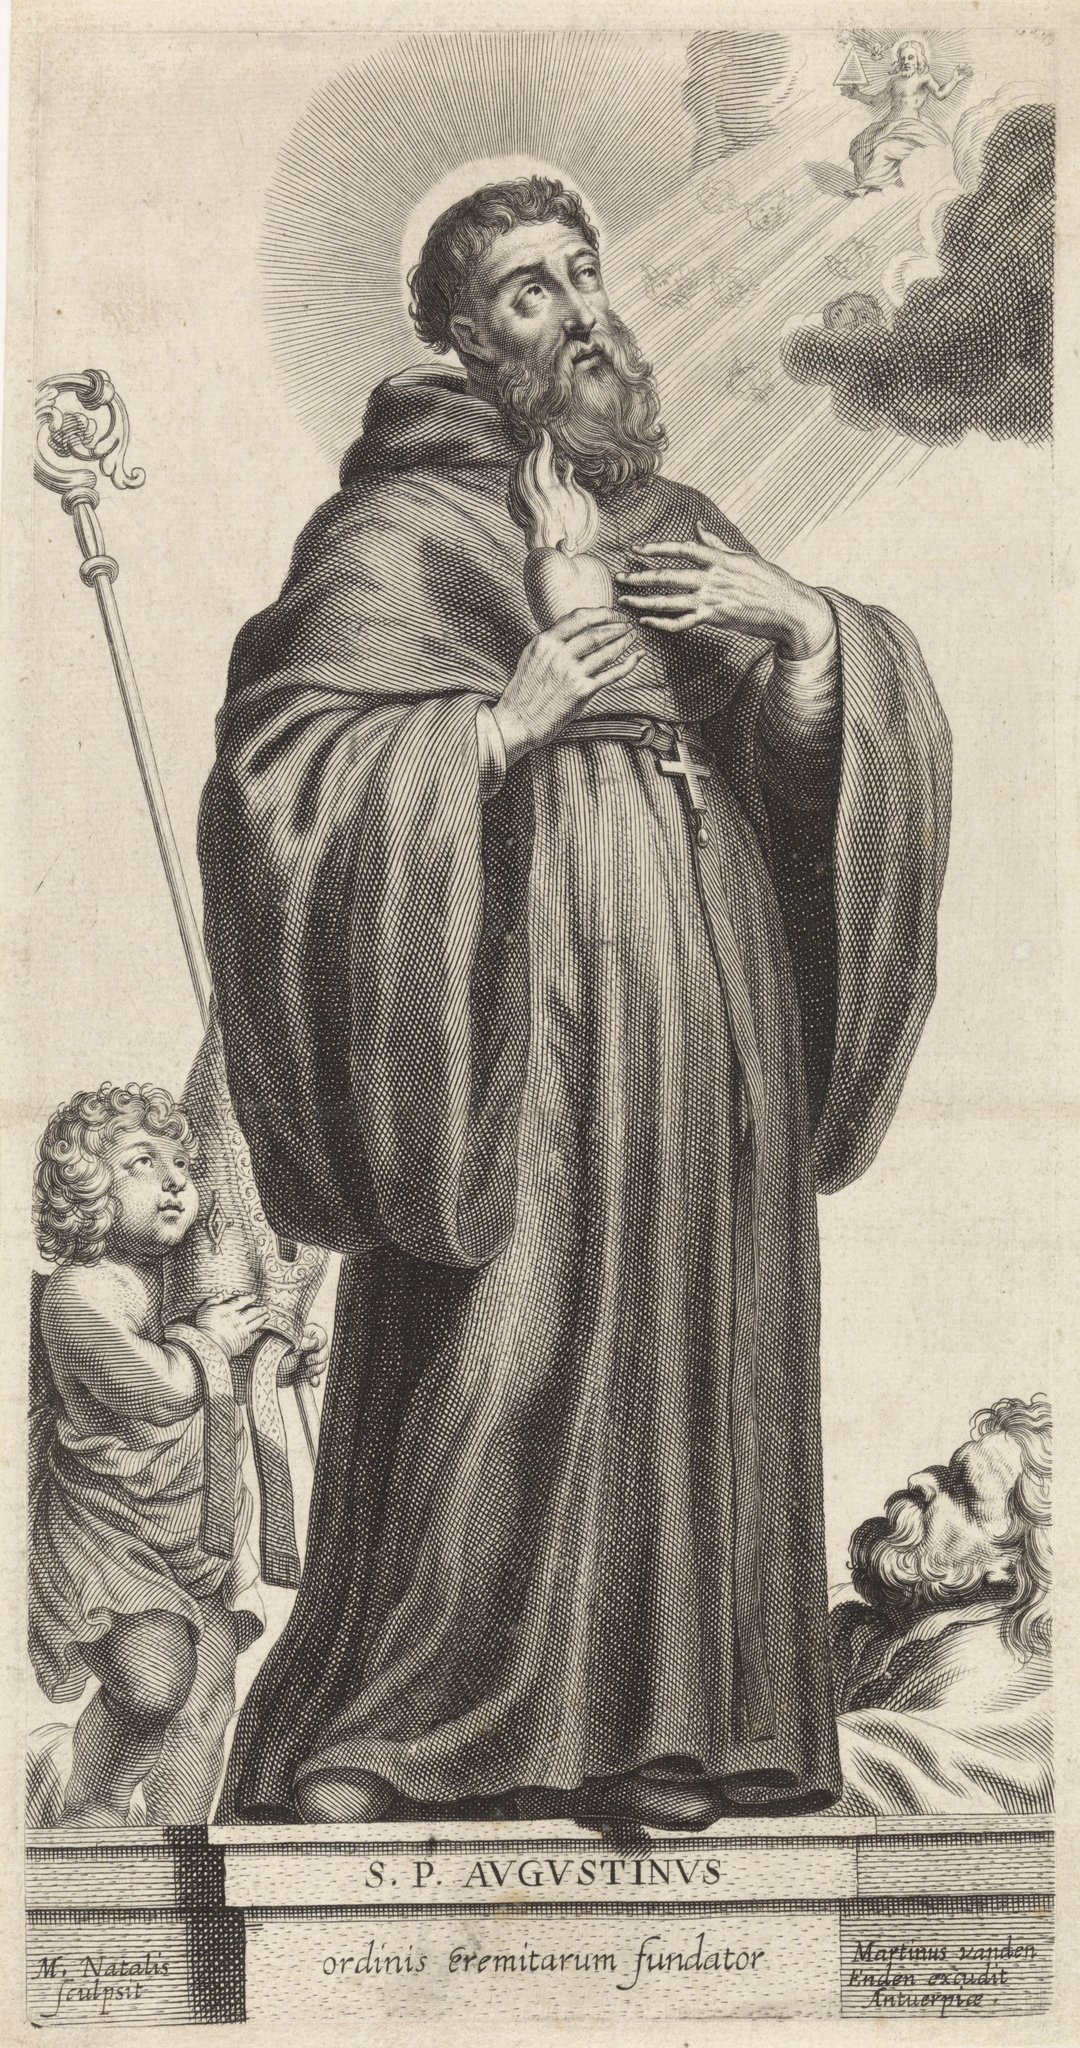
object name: print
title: S.P. Augustinus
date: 1620-1668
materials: paper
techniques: engraving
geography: antwerp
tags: augustine, bishop of hippo; possible attributes: arrows piercing his breast, book, child with spoon, flaming heart, heart (pierced with arrows), pen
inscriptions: collector's mark: Lugt 240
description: De heilige Augustinus van Hippo als augustijnermonnik, een vlammend hart in de hand, opkijkend naar Christus op de wolken. Christus houdt het tetragram, het symbool van God in de hand, daarnaast de duif van de Heilige Geest. Achter Augustinus draagt een jongen de bisschopsmijter en staf. Onderaan op het pedestal een regel tekst in het Latijn. Prent uit een serie van heiligen.